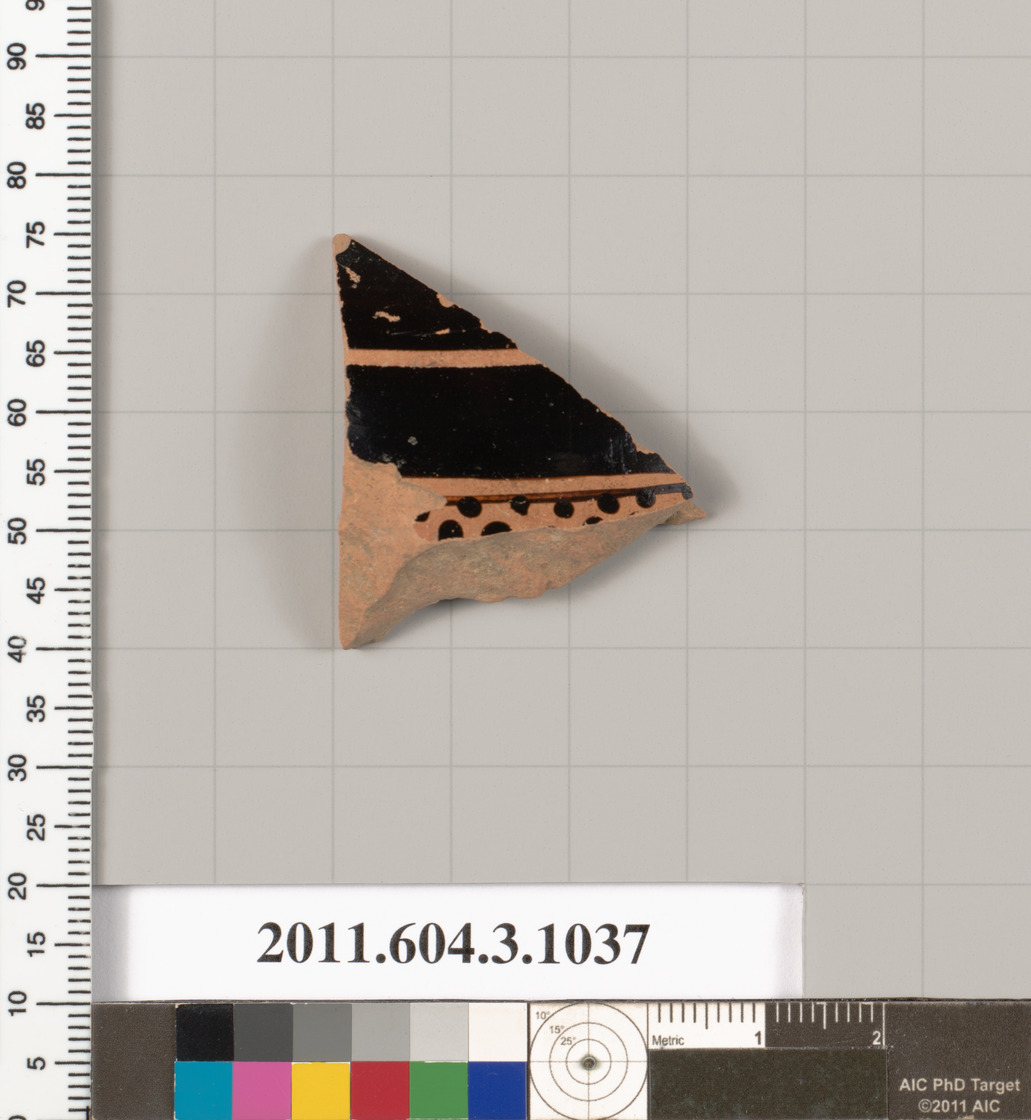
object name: fish plate fragment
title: Terracotta fragment of a fish plate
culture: greek, attic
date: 534-501 BCE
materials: terracotta